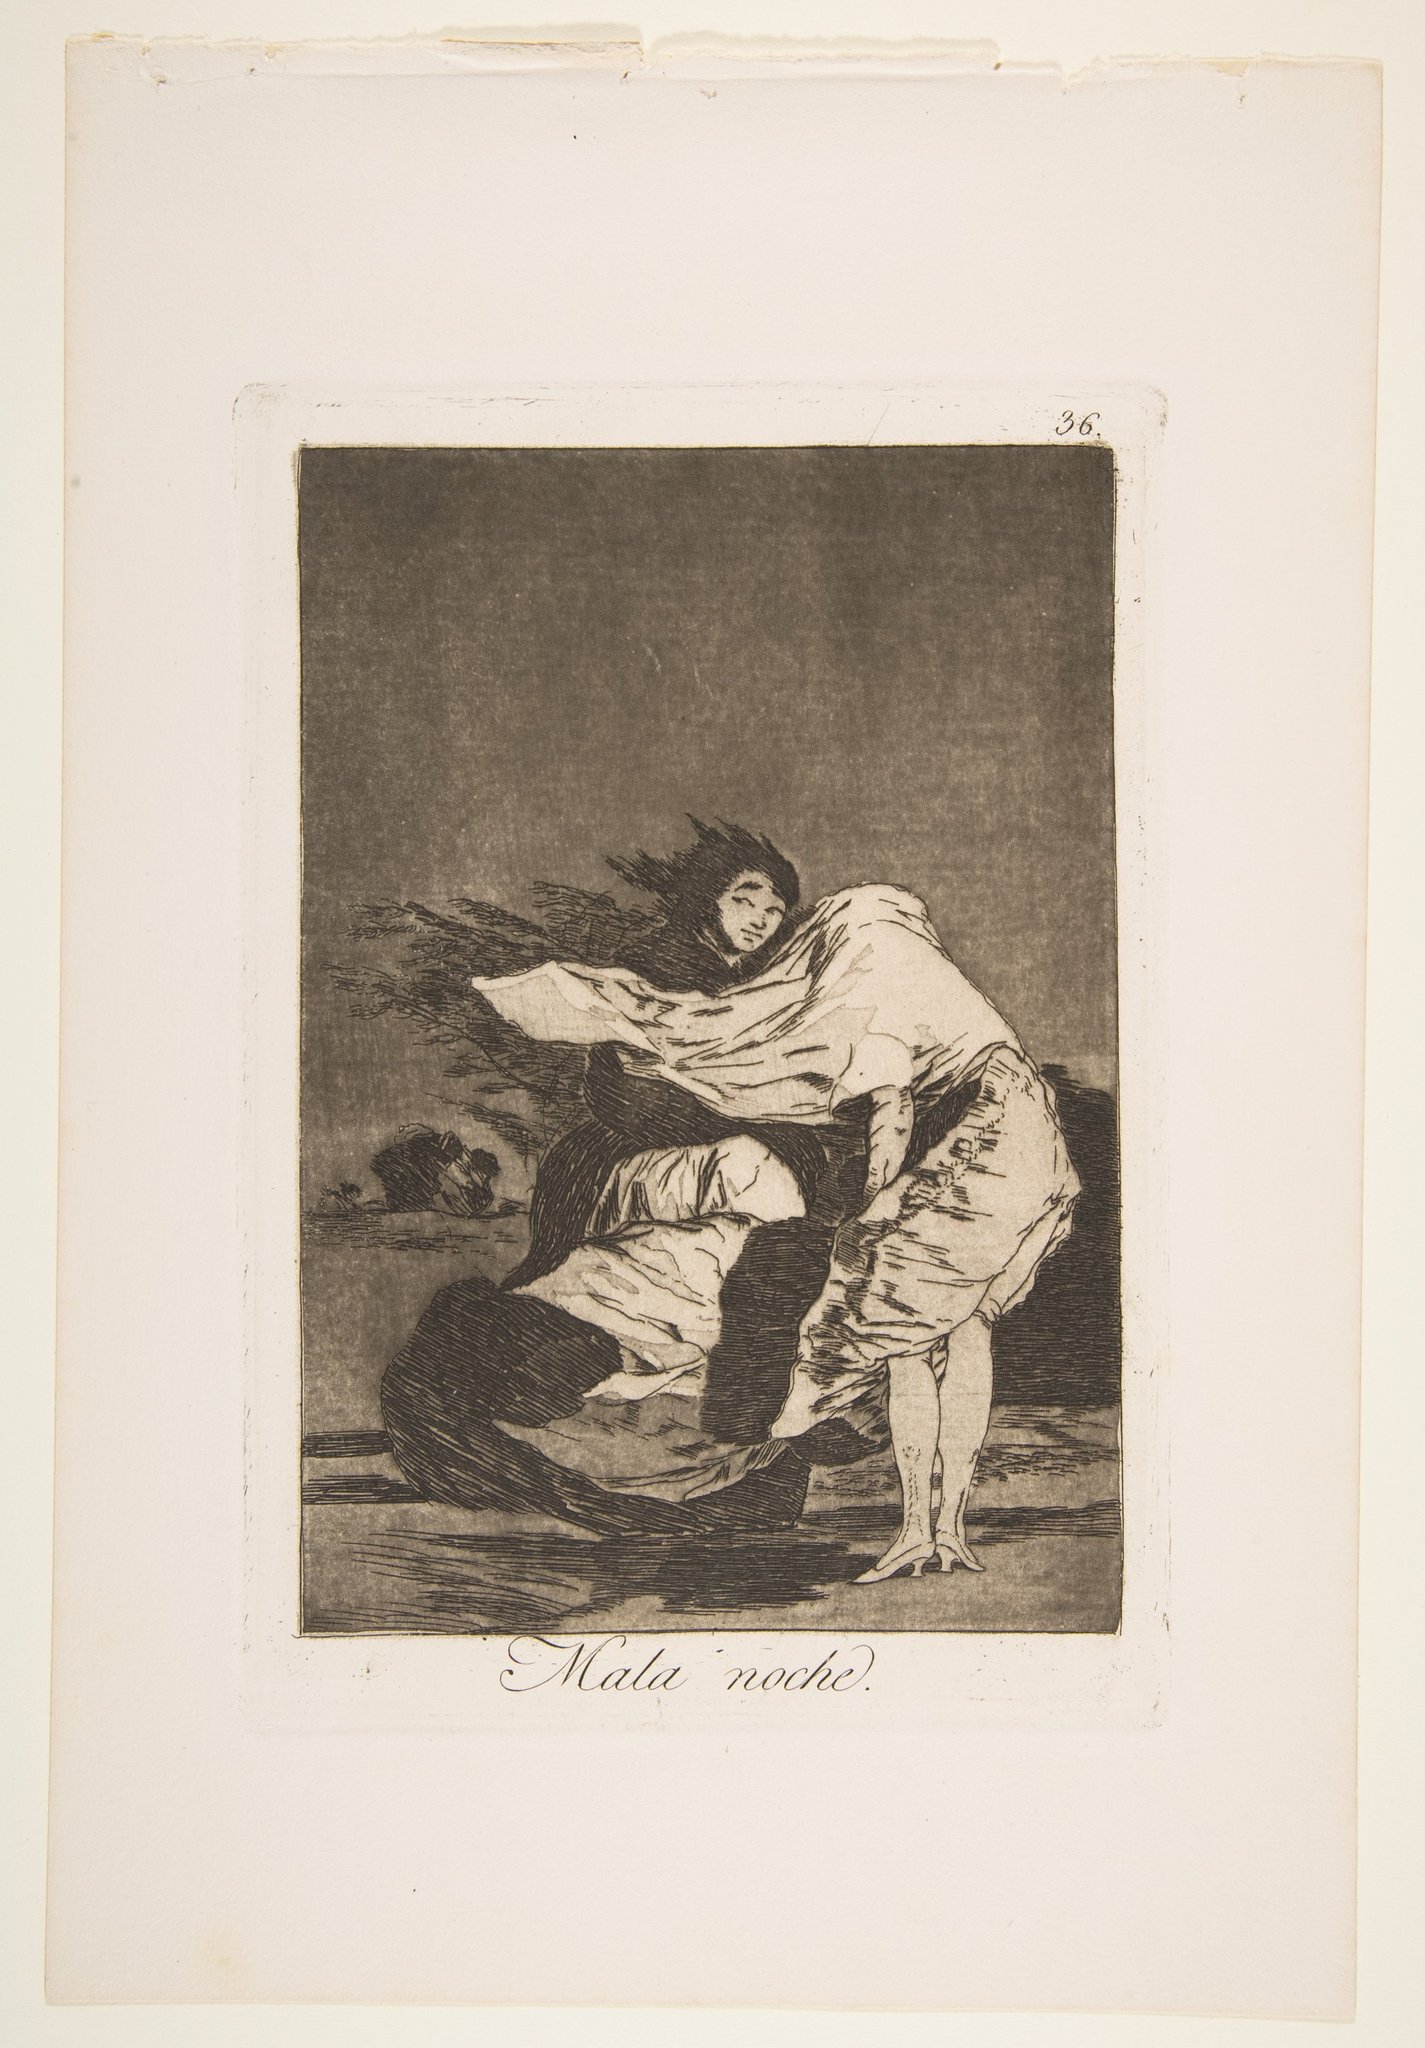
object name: print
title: Plate 36 from "Los Caprichos": A bad night (Mala noche)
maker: goya (francisco de goya y lucientes)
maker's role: artist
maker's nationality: spanish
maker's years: 1746-1828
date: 1881-1886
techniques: aquatint, burnishing, etching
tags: human figures,night